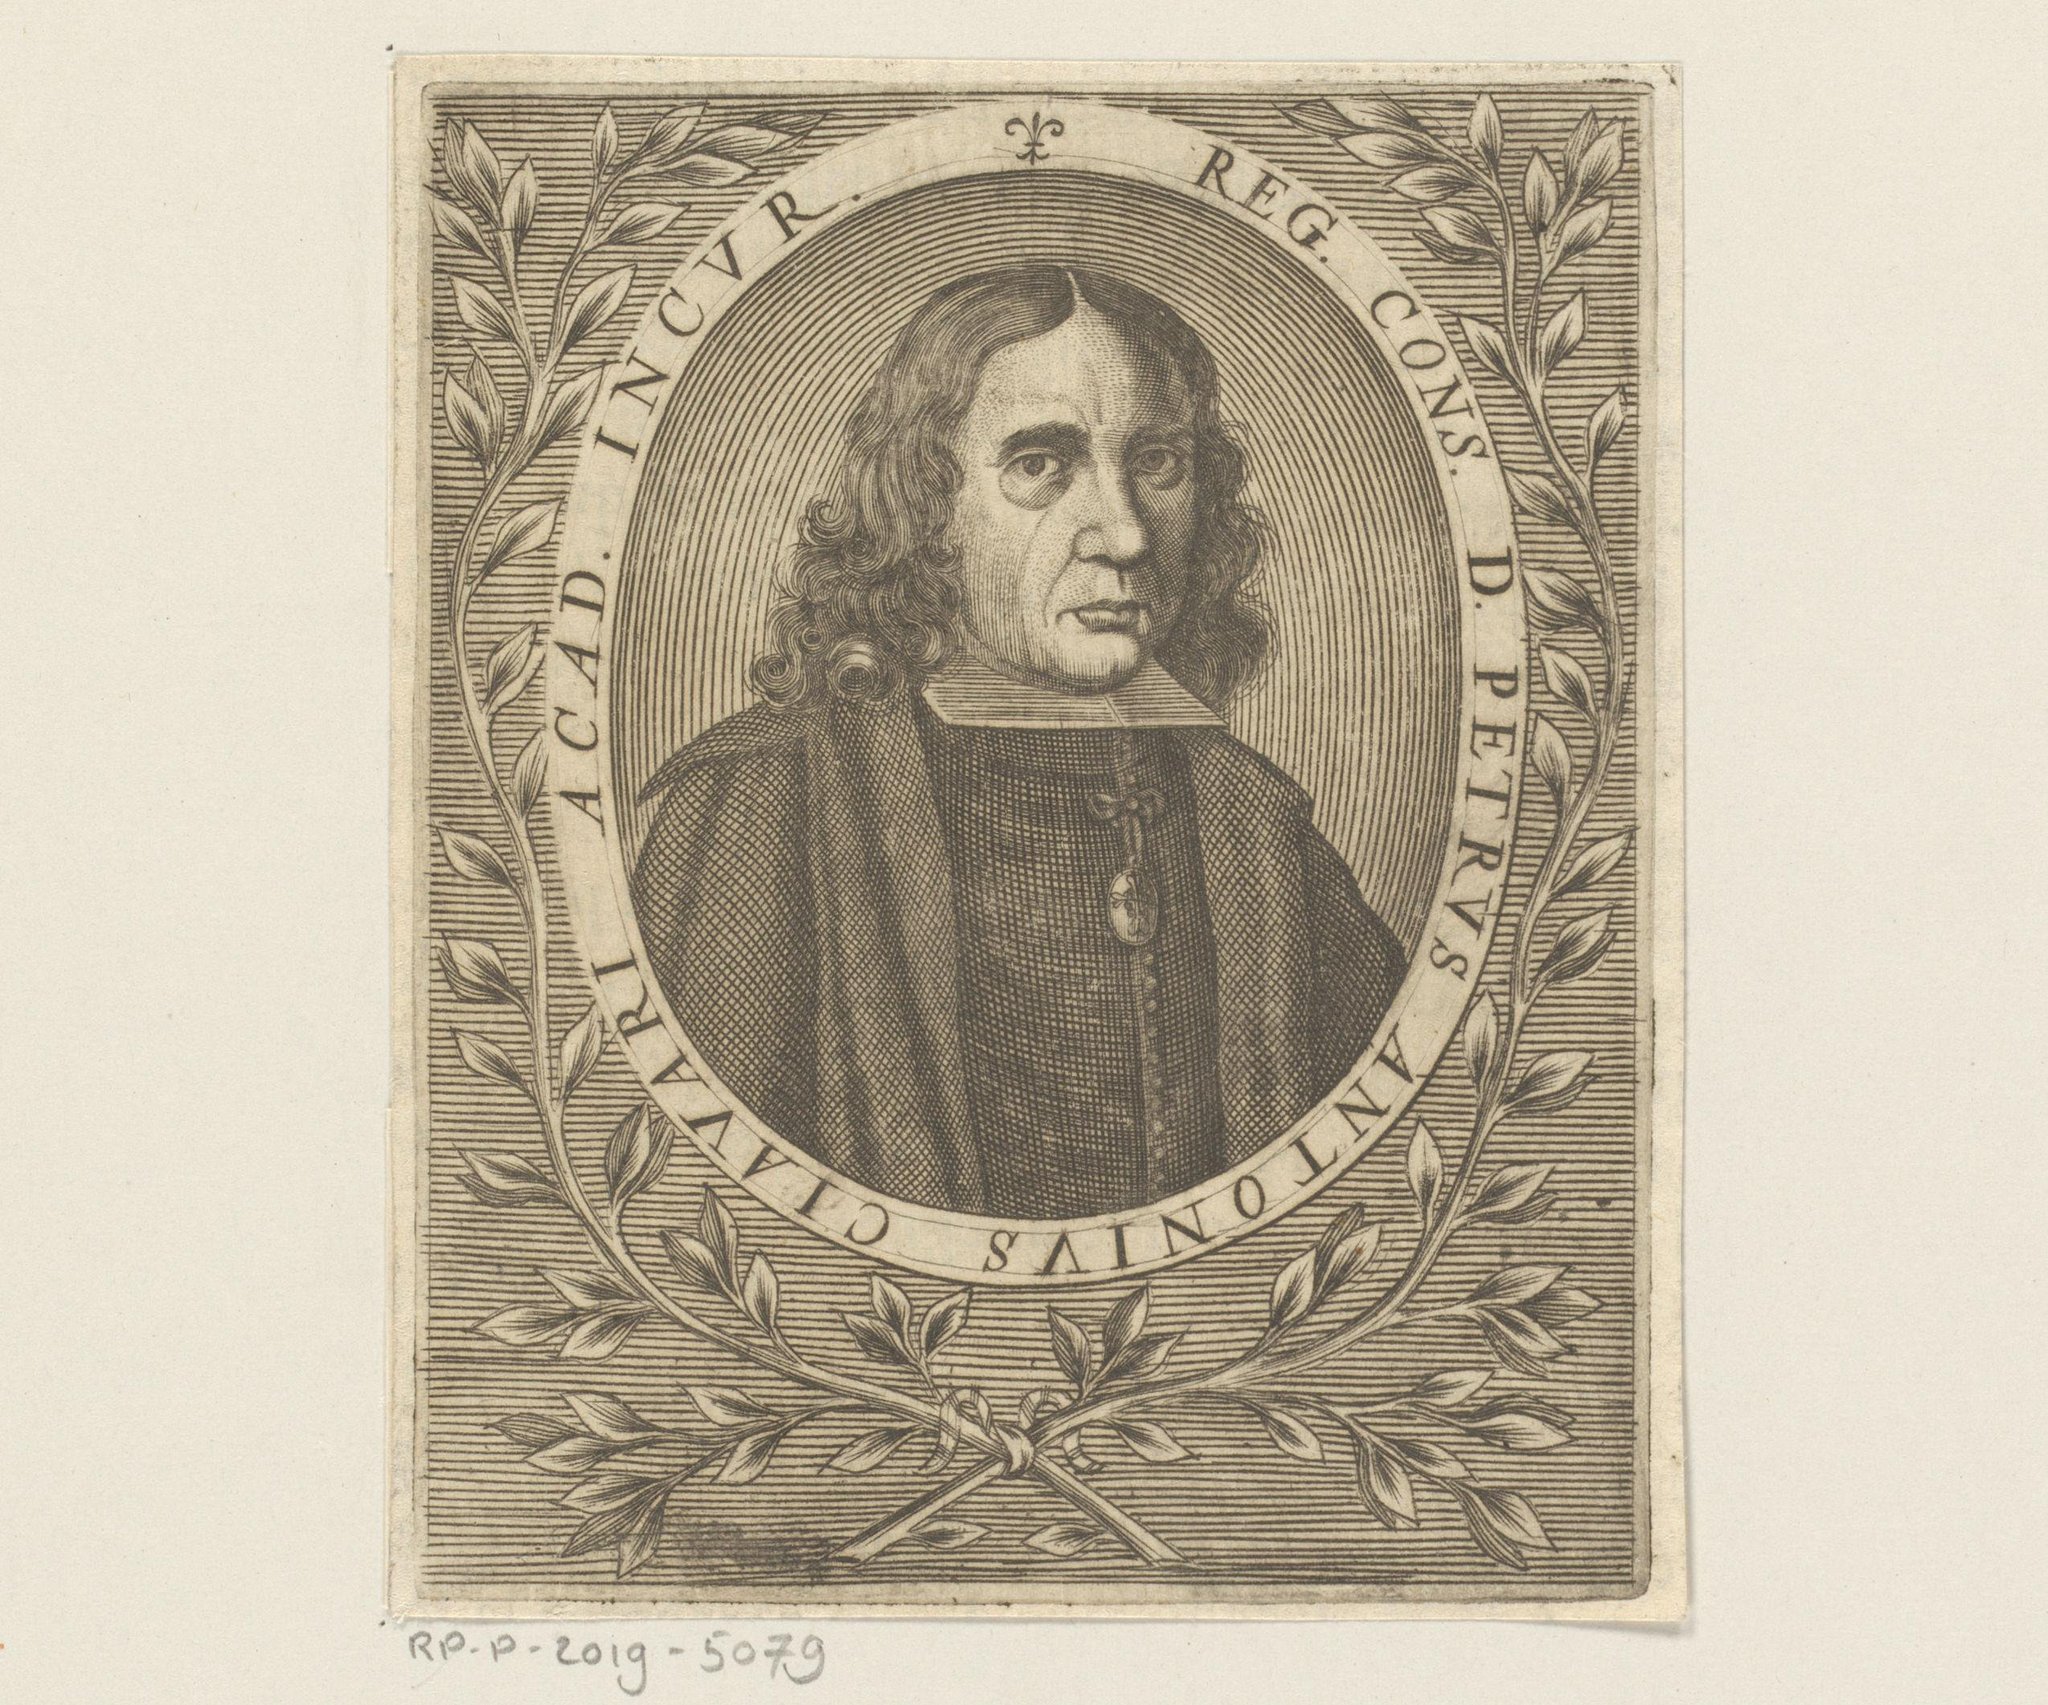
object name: book illustration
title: Portret van Pietro Antonio Ciavari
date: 1703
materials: paper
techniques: engraving, etching, letterpress printing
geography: naples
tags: historical persons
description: Prent uit: Gimma, Giacinto. Elogj accademici della Società degli Spensierati di Rossano (...). Napels: Carlo Troise, 1703, p. 253.